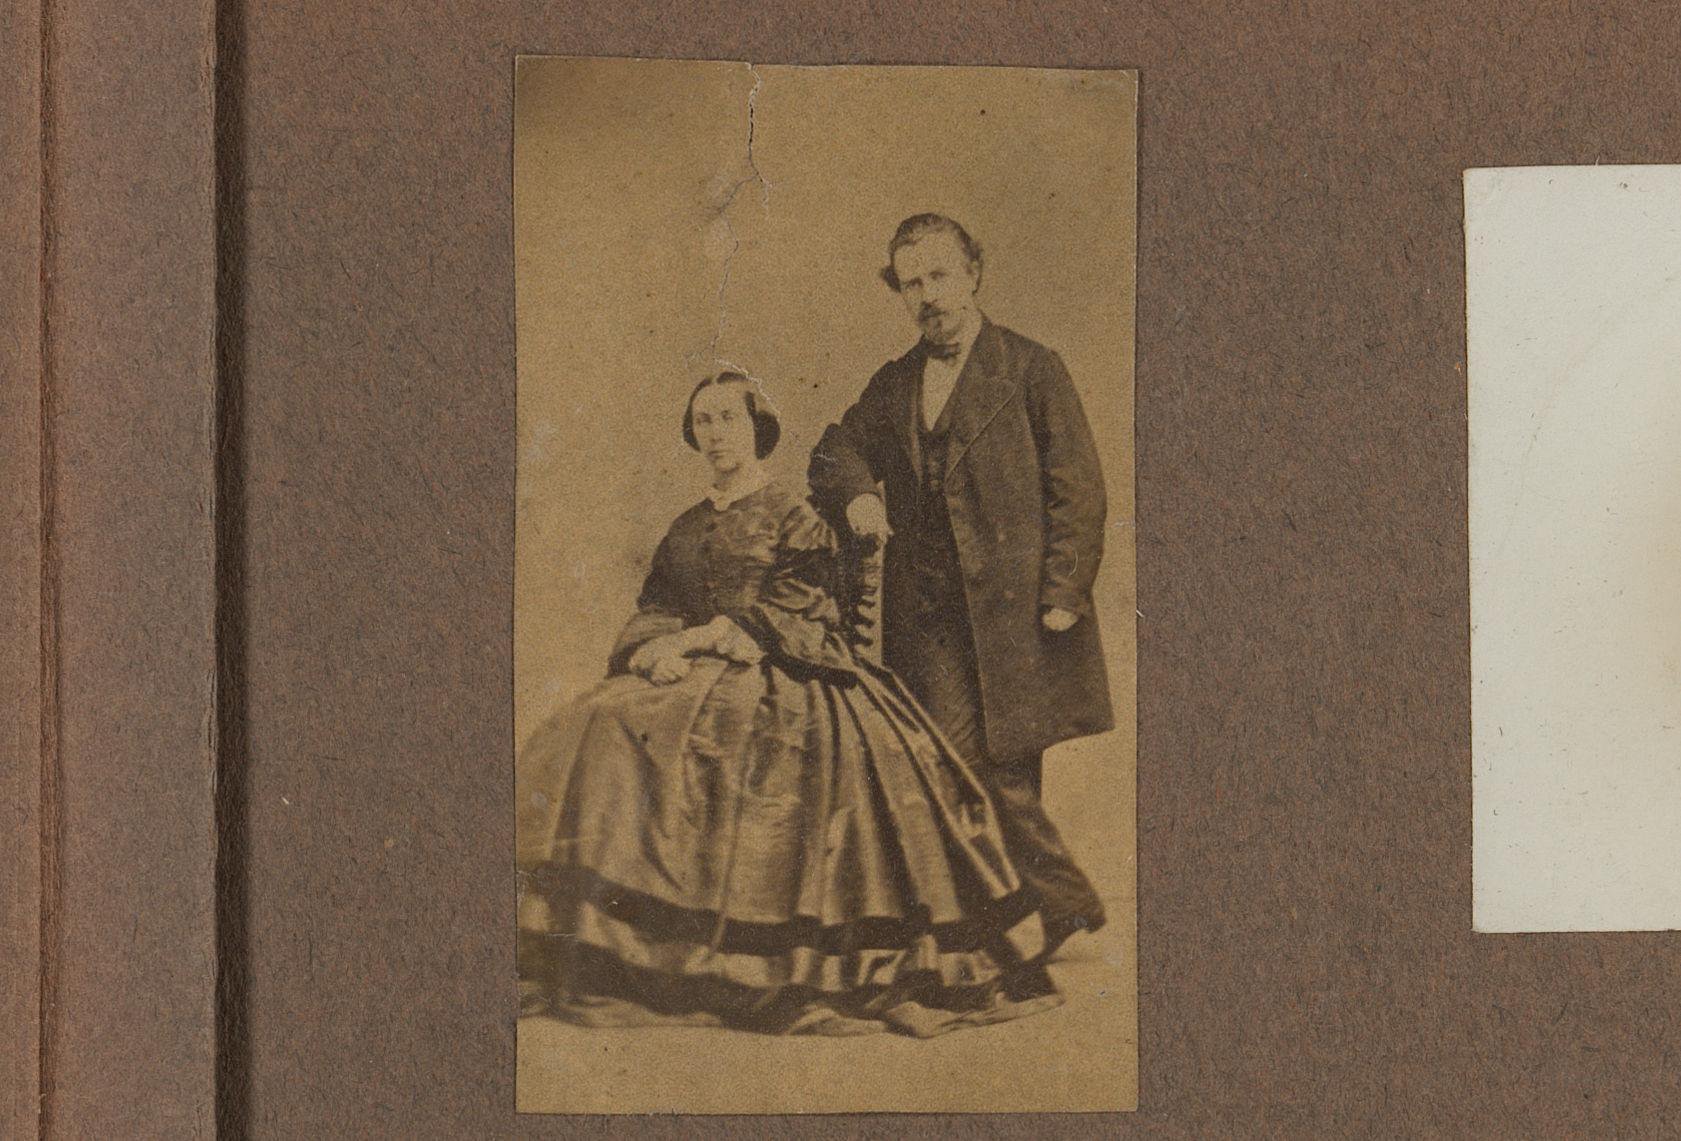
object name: photograph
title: Portret van vrouw en man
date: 1870-1920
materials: photographic support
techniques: photography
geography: netherlands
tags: netherlands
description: Foto op bruin albumblad 37 van familiealbum van Alphons Diepenbrock.